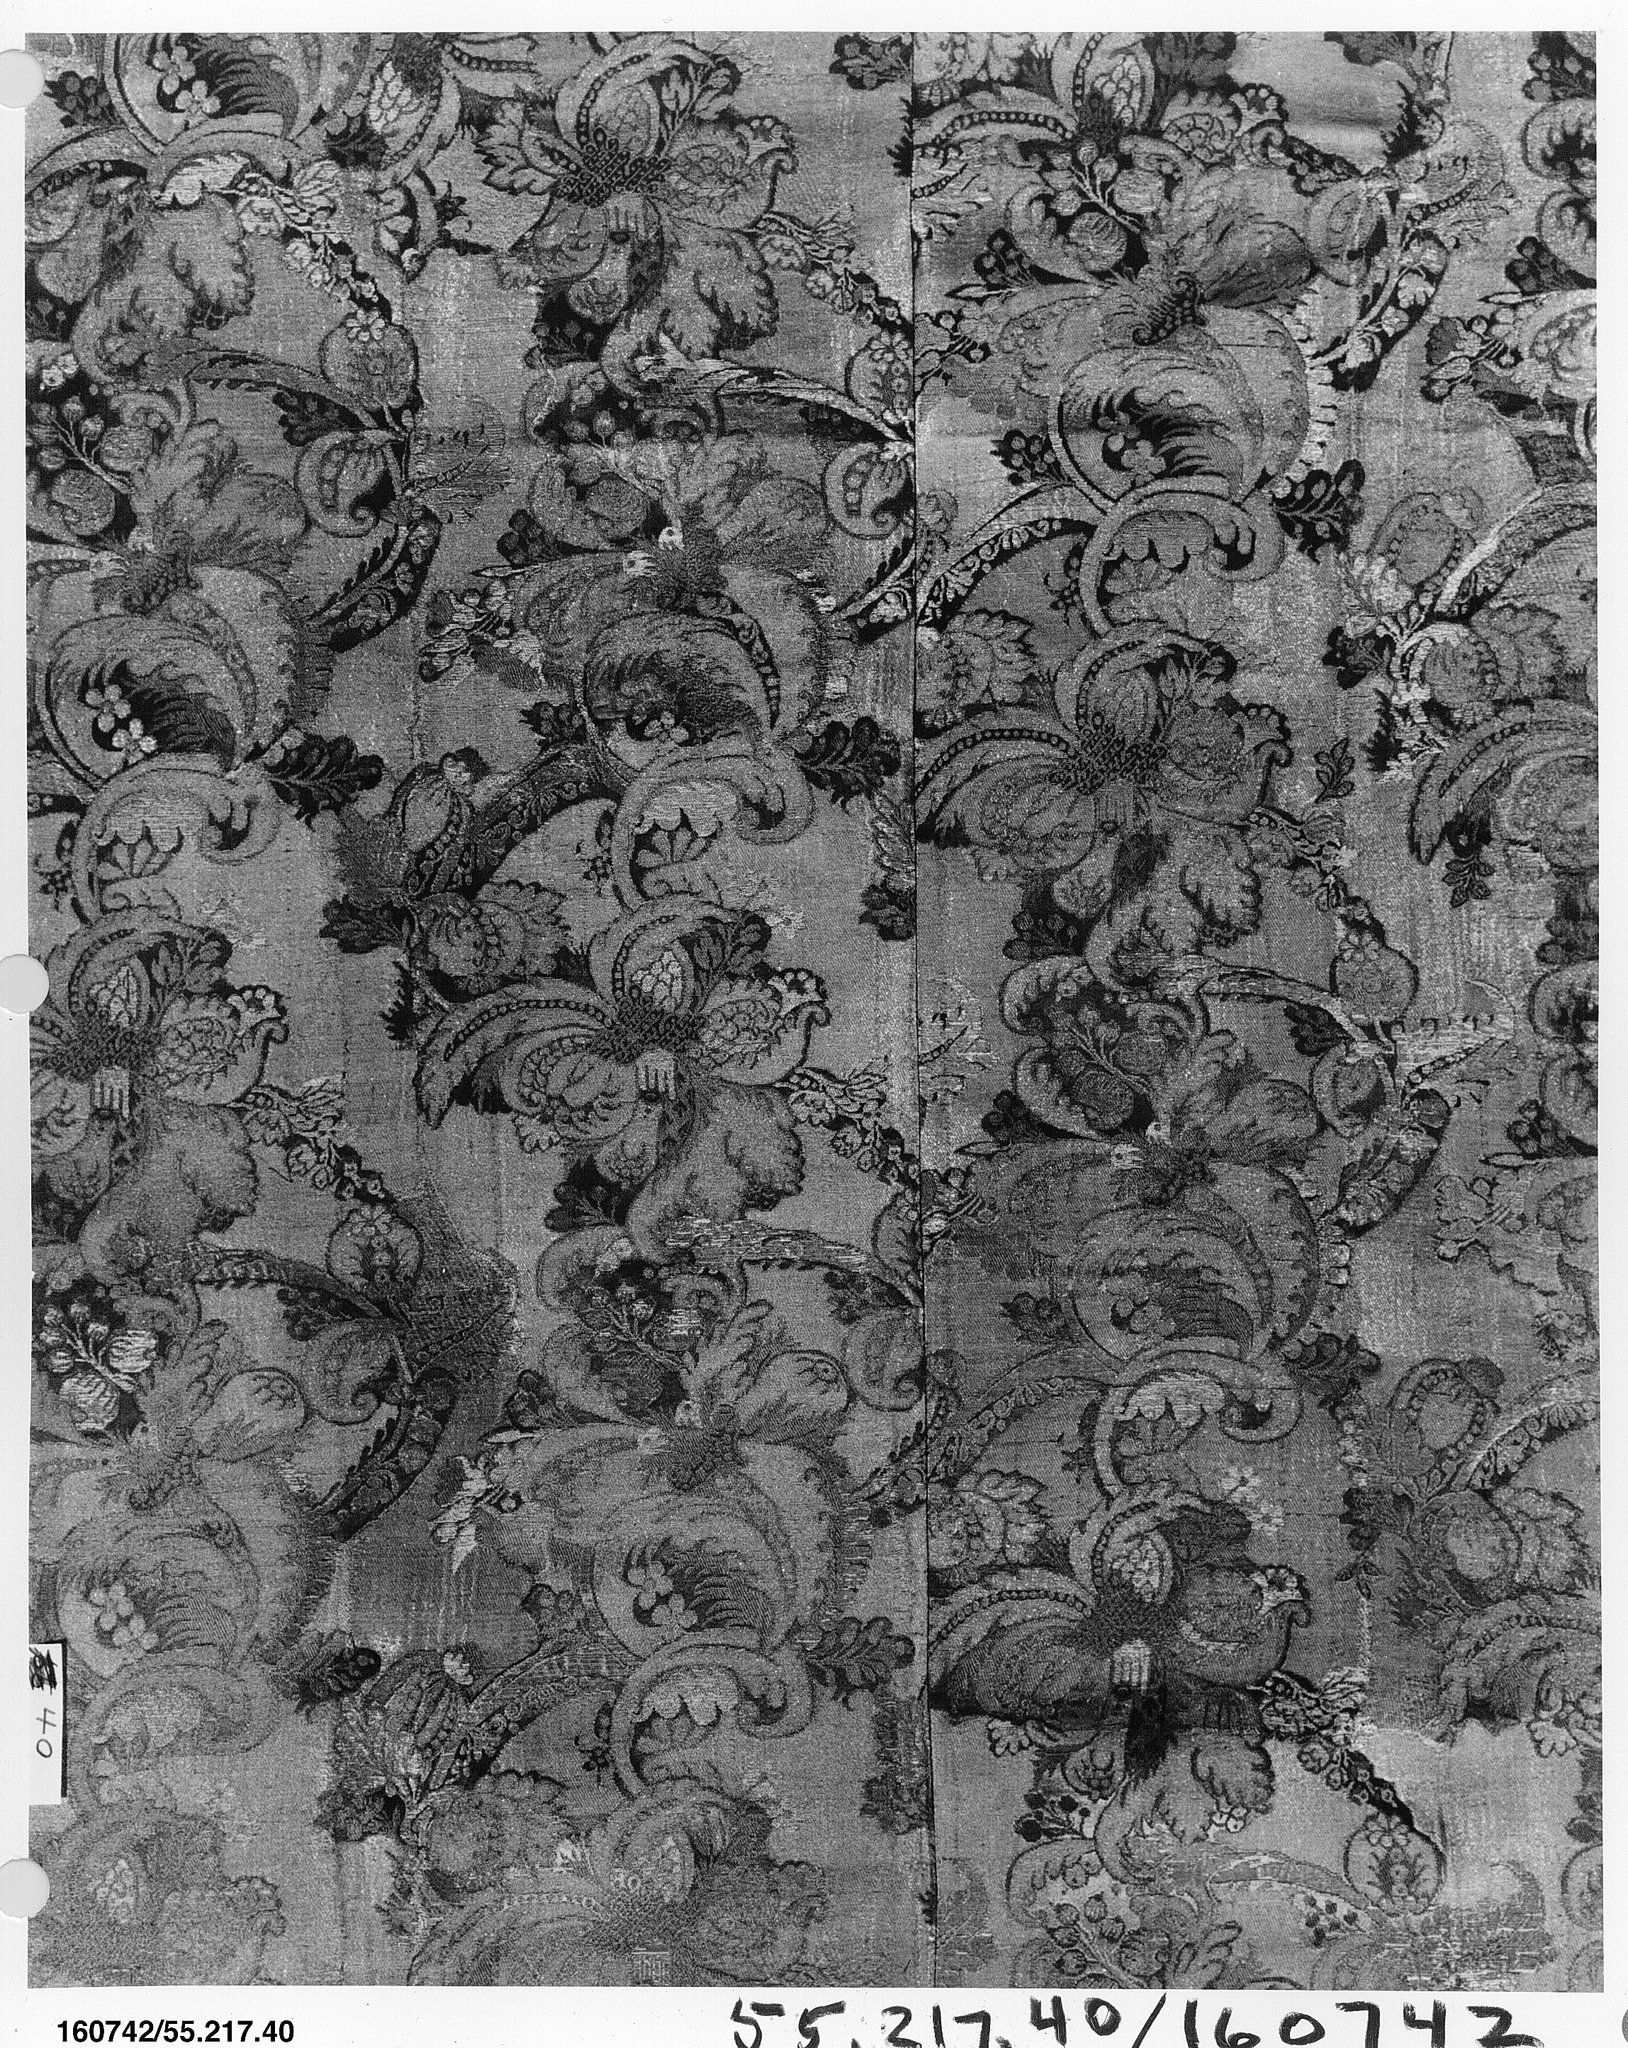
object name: piece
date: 1720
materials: metal thread, silk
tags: flowers,leaves